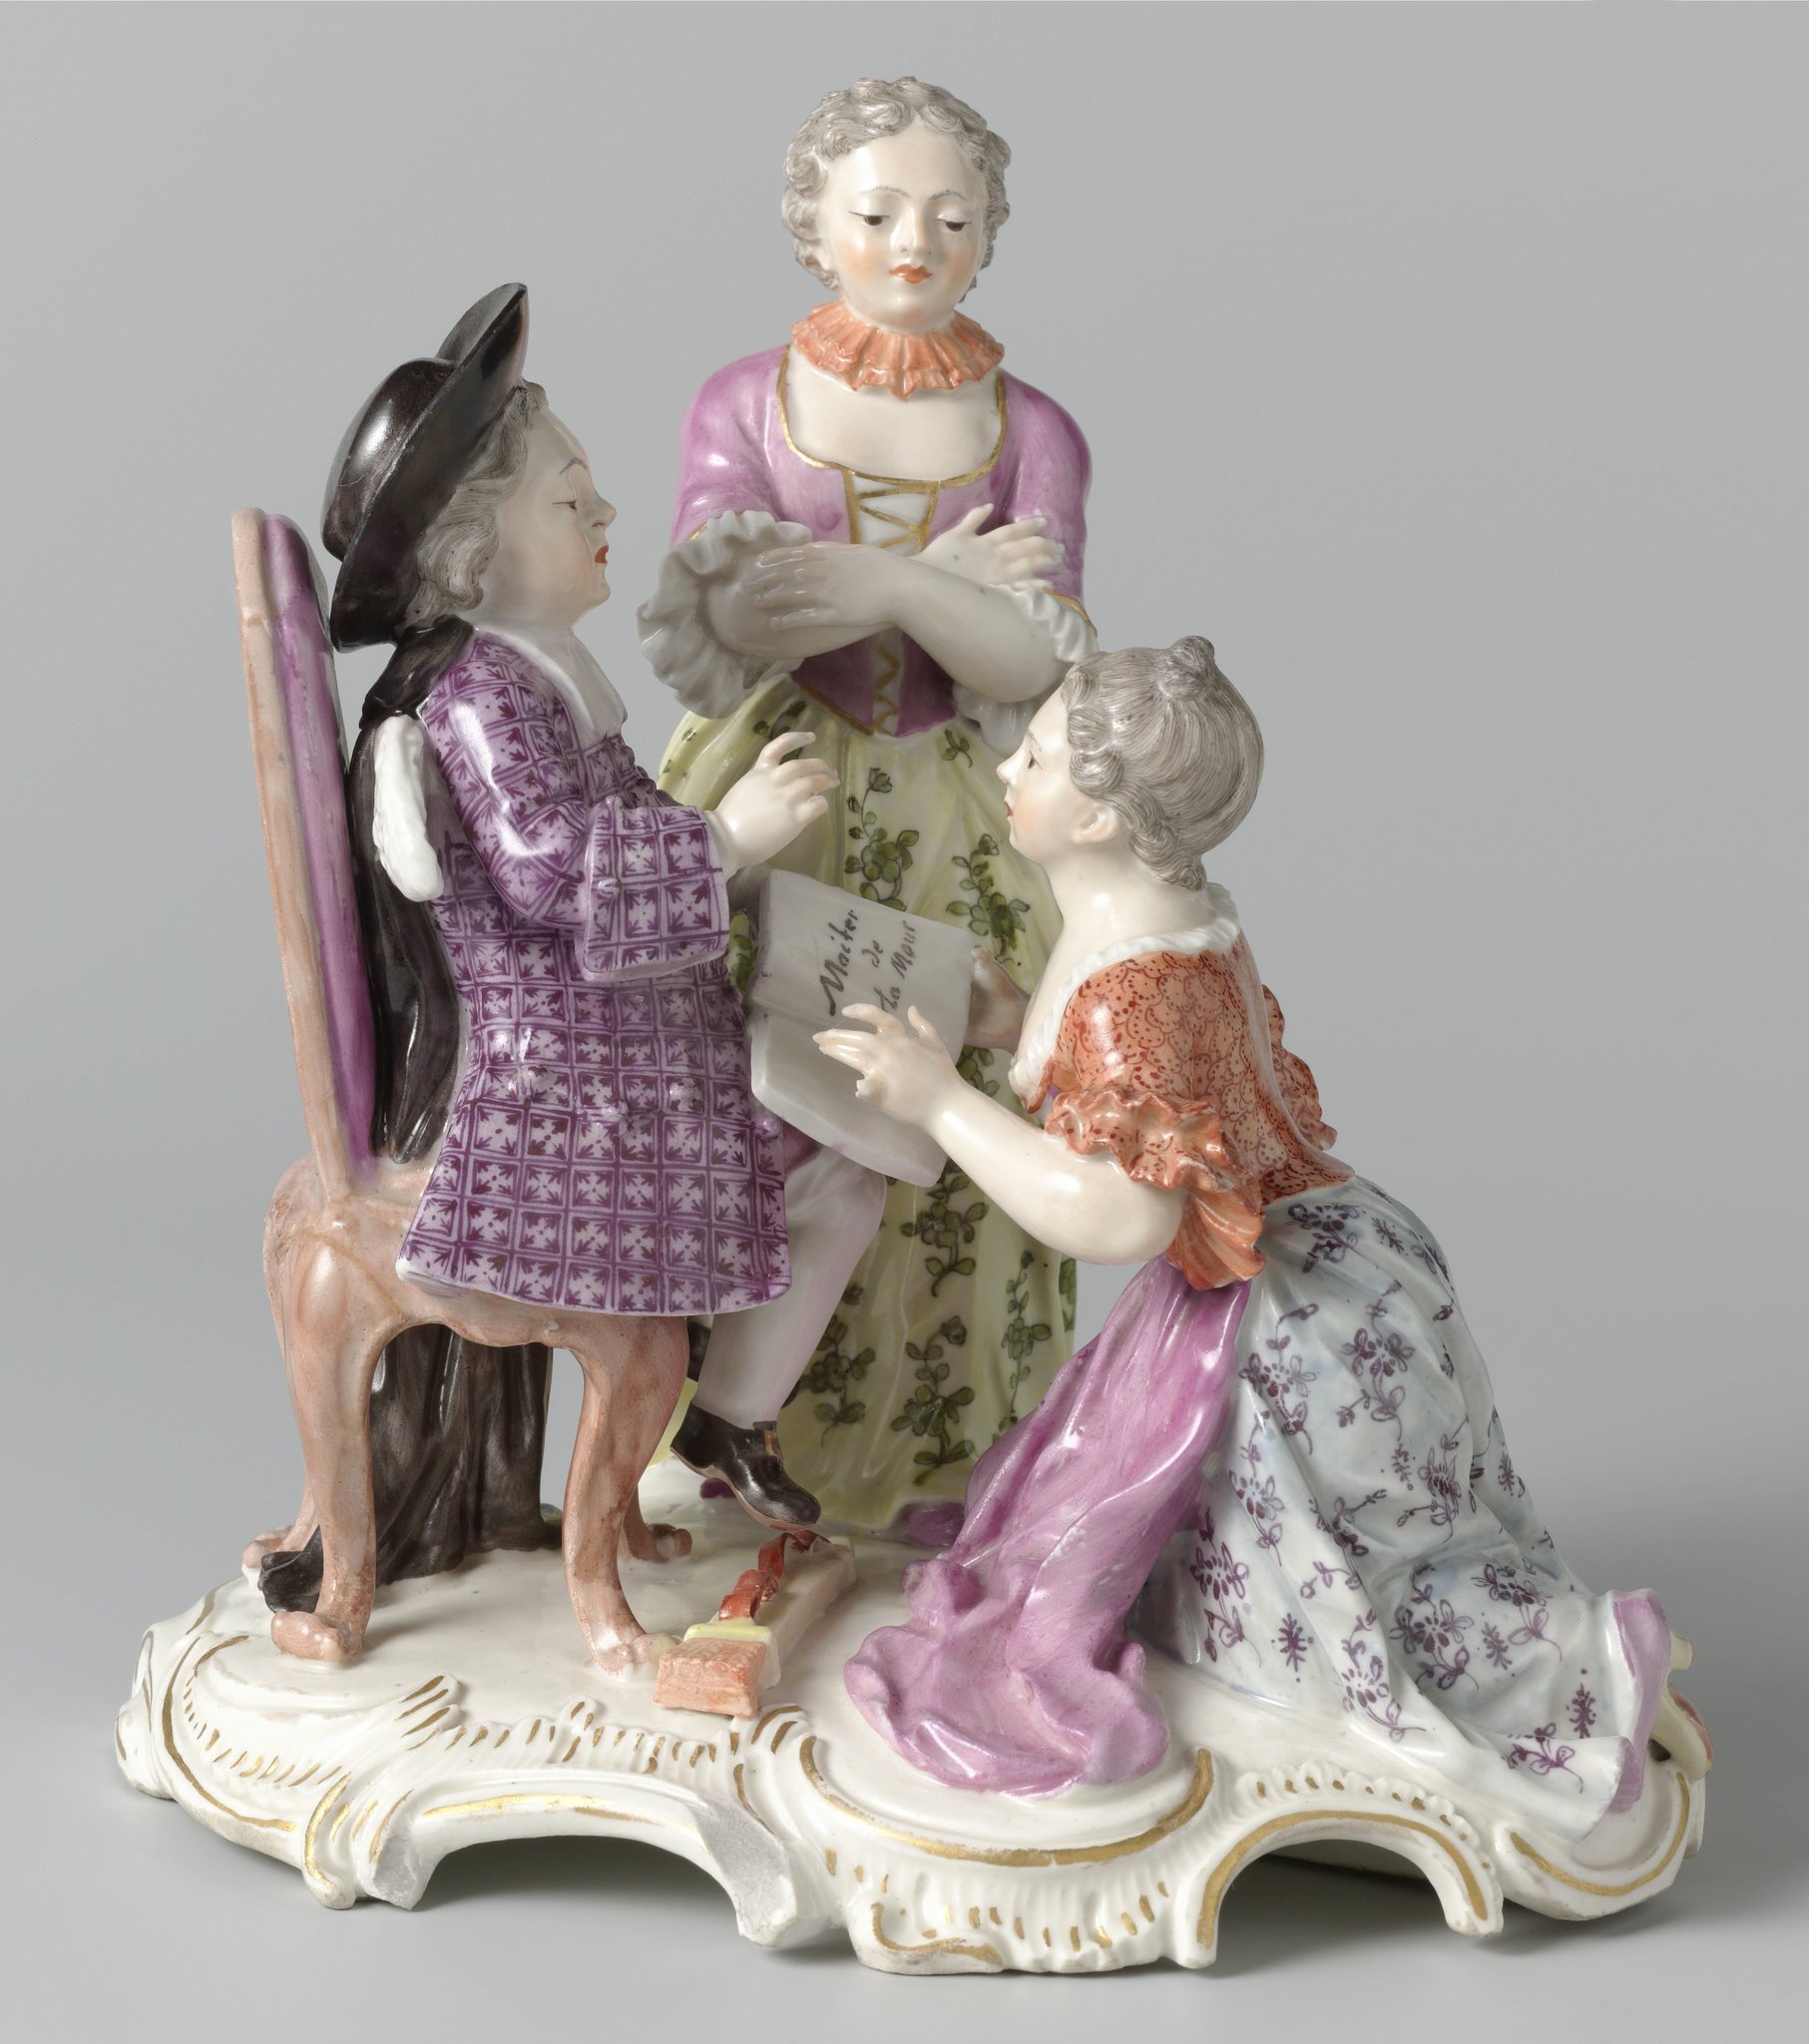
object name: figure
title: Figure of a winged man who is teaching about love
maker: johann wilhelm lanz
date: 1755-1759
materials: glaze, gold, paint, porcelain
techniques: firing, forming, gilding, vitrification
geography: frankenthal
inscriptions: mark: ‘leeuw/ PH6/ N (gespiegeld)’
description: The lesson in love. Porcelain. Frankenthal, c. 1755 - 1759, model by Johann Wilhelm Lanz.